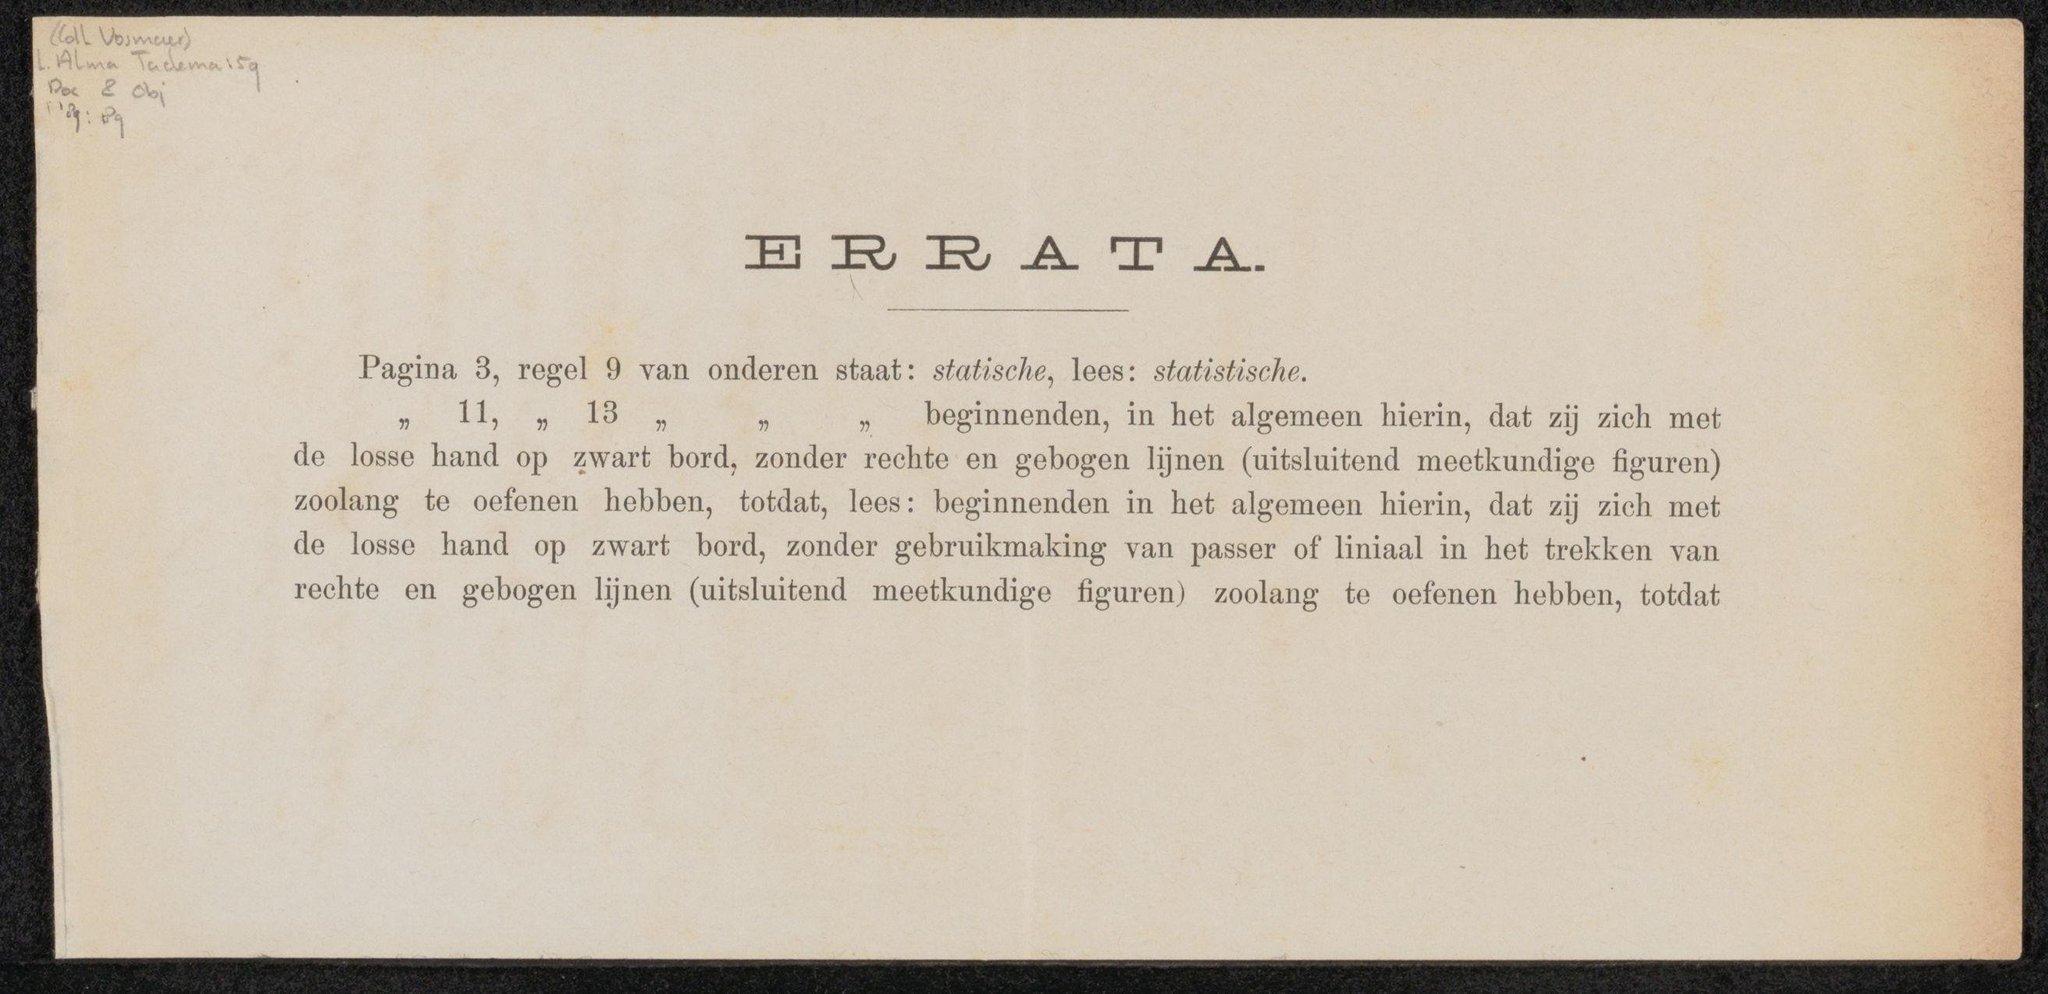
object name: letter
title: Brief aan Carel Vosmaer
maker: lourens alma tadema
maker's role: draughtsman, print maker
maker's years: 1836-1912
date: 1881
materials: ink, paper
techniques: pen, printing, writing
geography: leipzig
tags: berlin, print maker, draughtsman, carel vosmaer, literature ~ arts